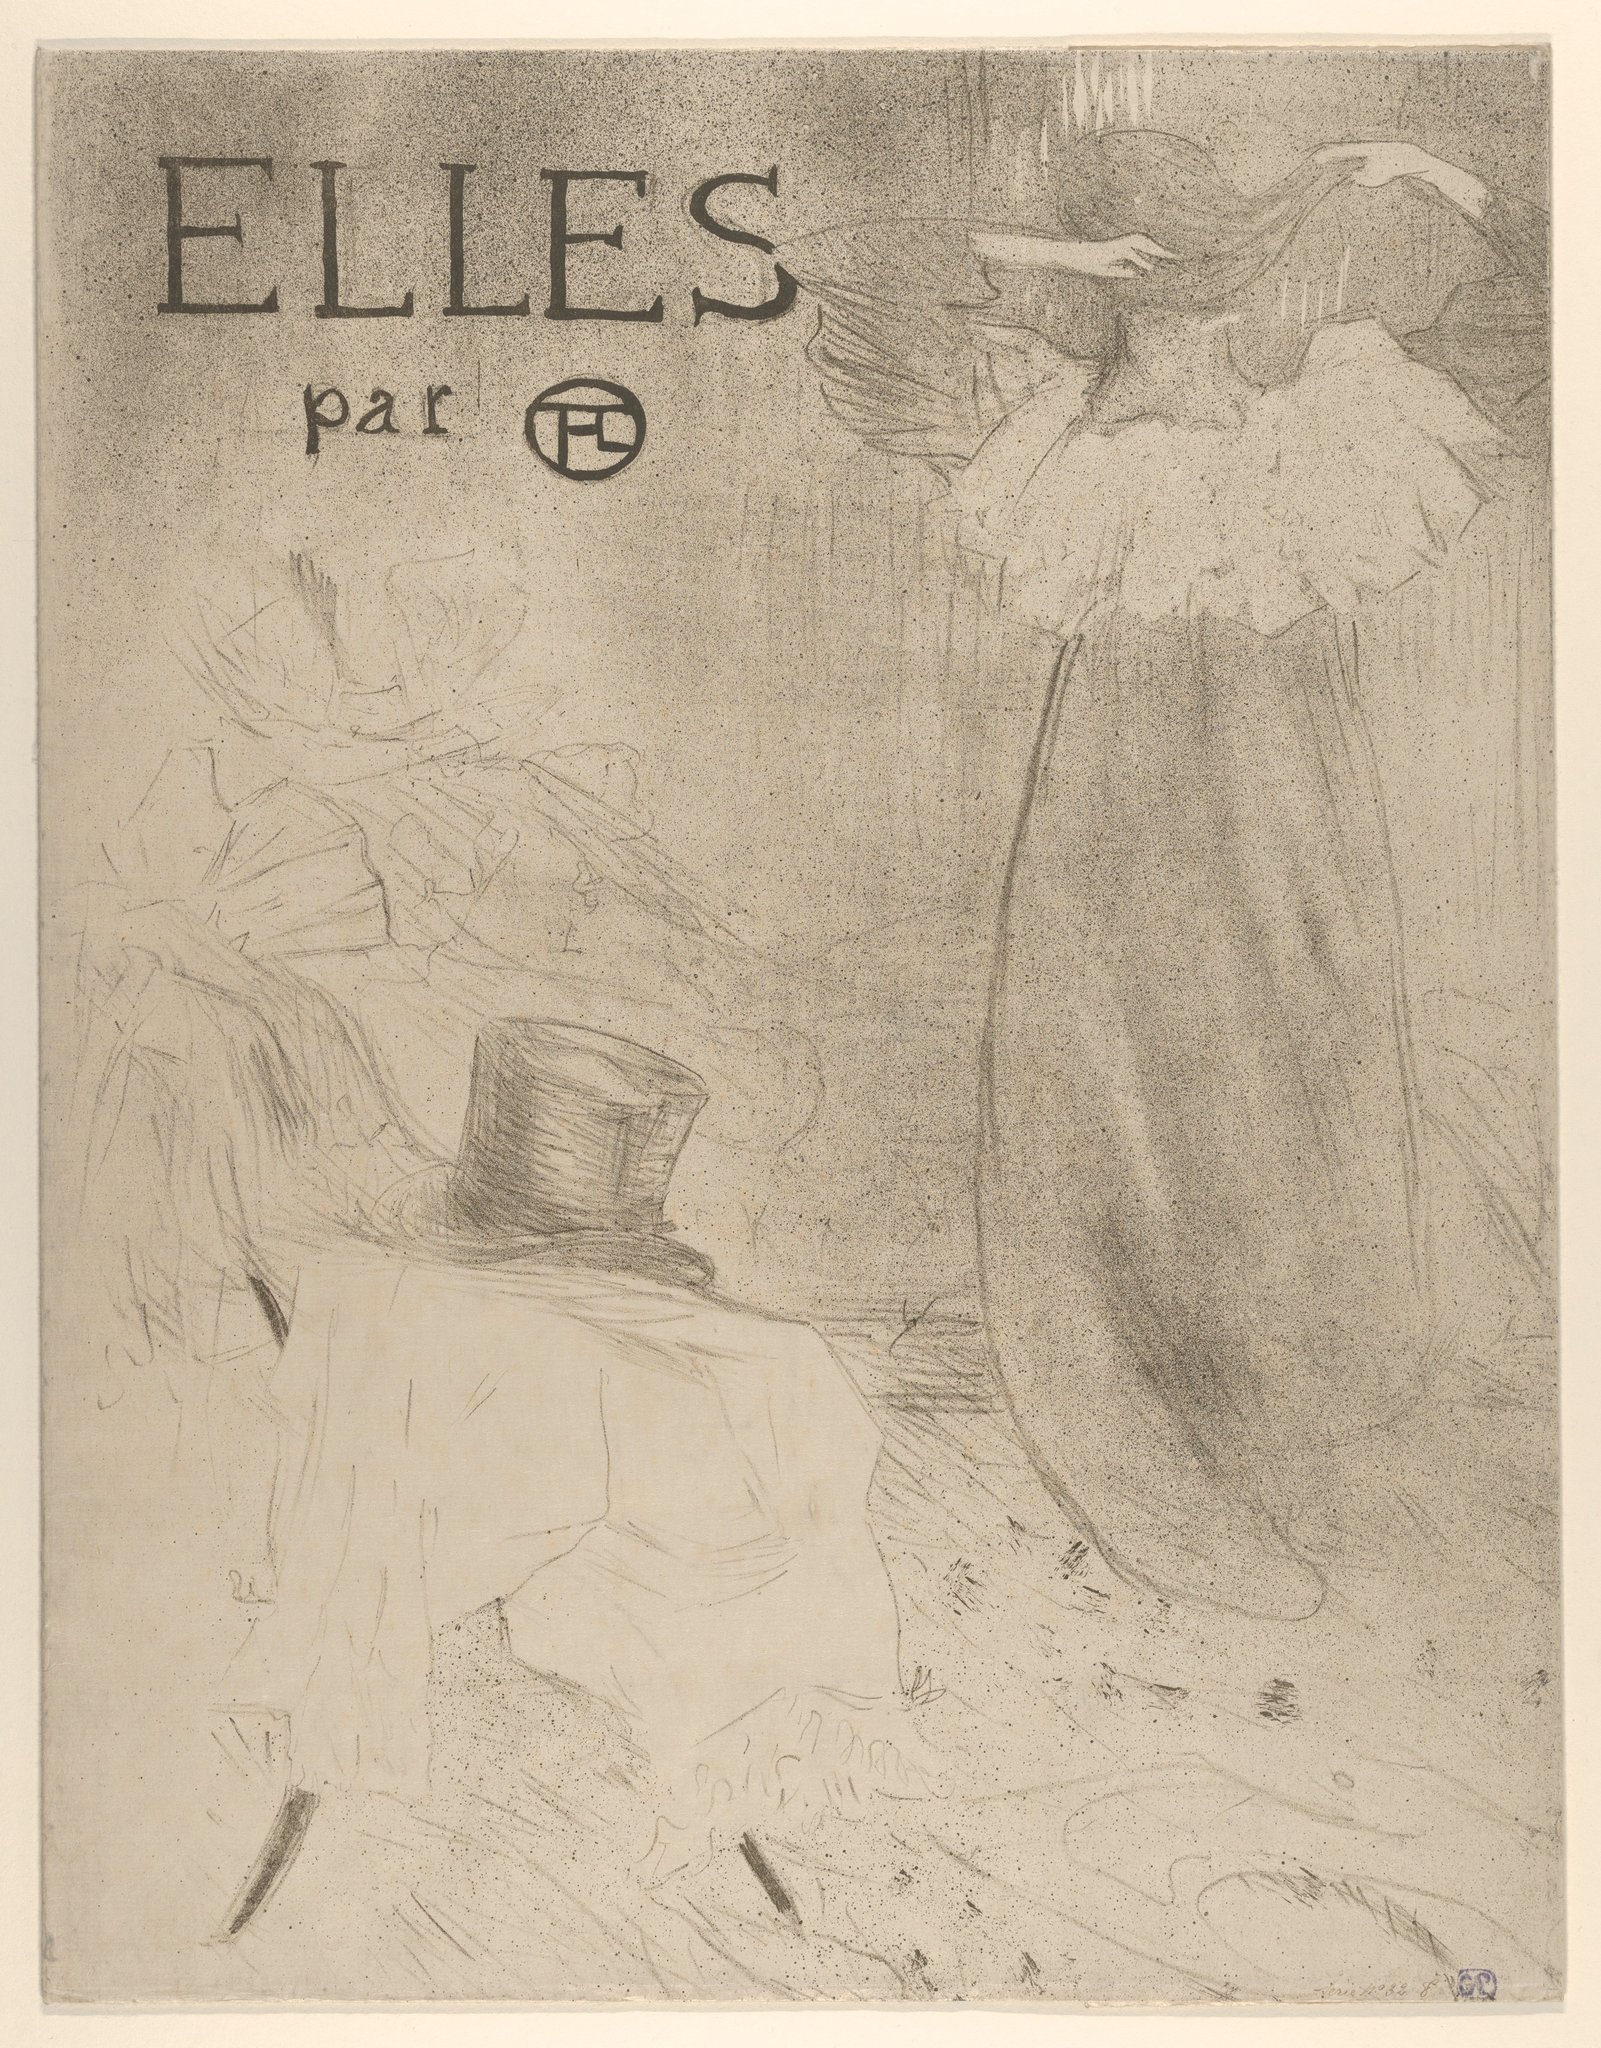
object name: print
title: Elles (portfolio cover)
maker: henri de toulouse-lautrec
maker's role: artist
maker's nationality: french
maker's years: 1864-1901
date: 1896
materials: crayon, paper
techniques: brush, lithograph, printing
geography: france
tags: hats,hair,women